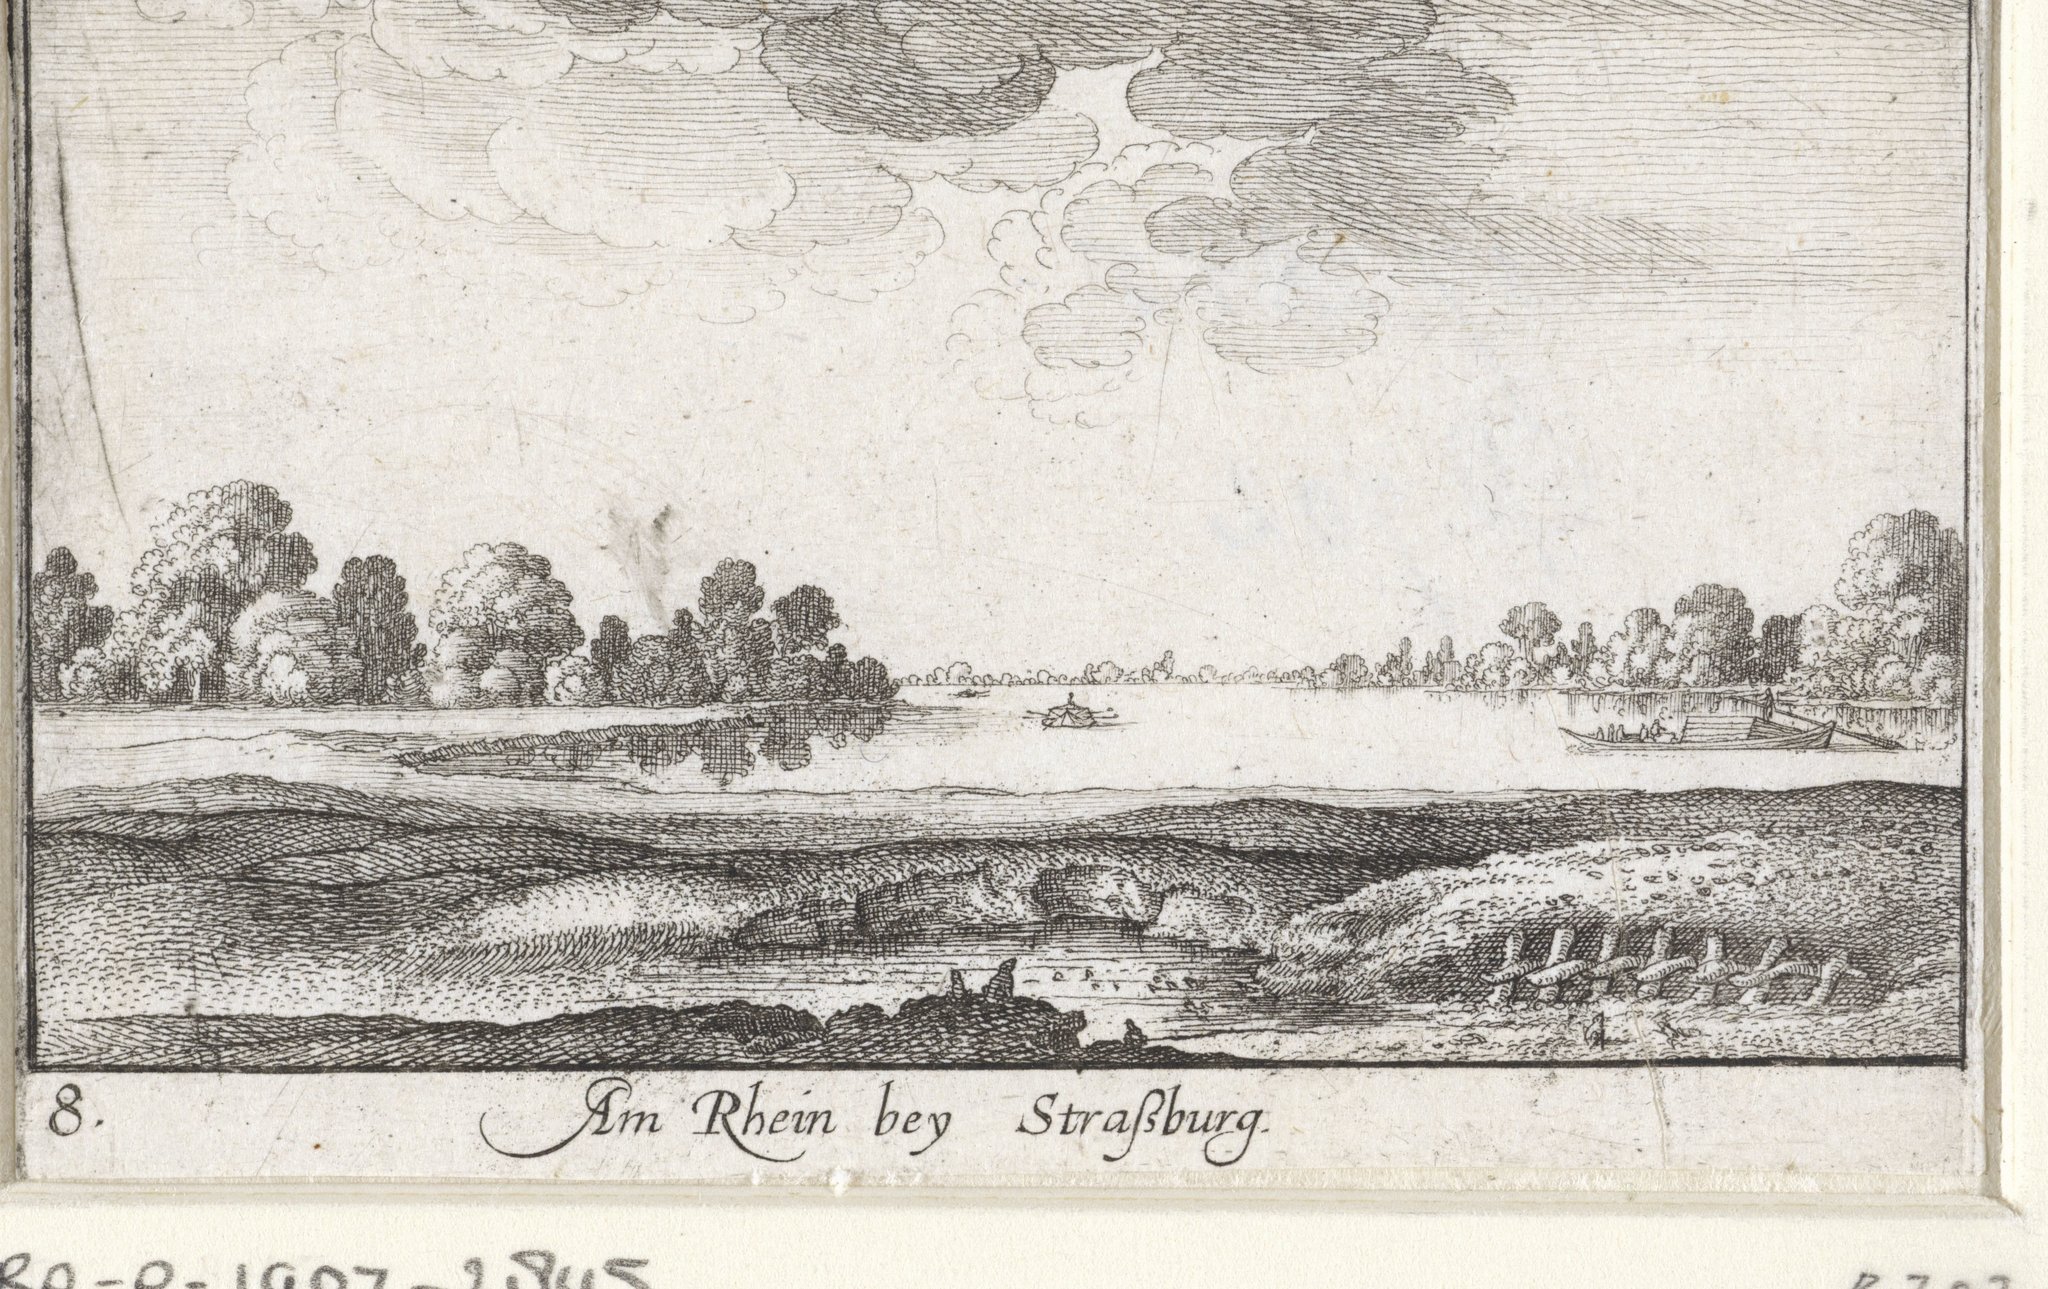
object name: print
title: Gezicht op de Rijn bij Straatsburg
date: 1635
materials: paper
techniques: etching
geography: cologne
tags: city-view, and landscape with man-made constructions